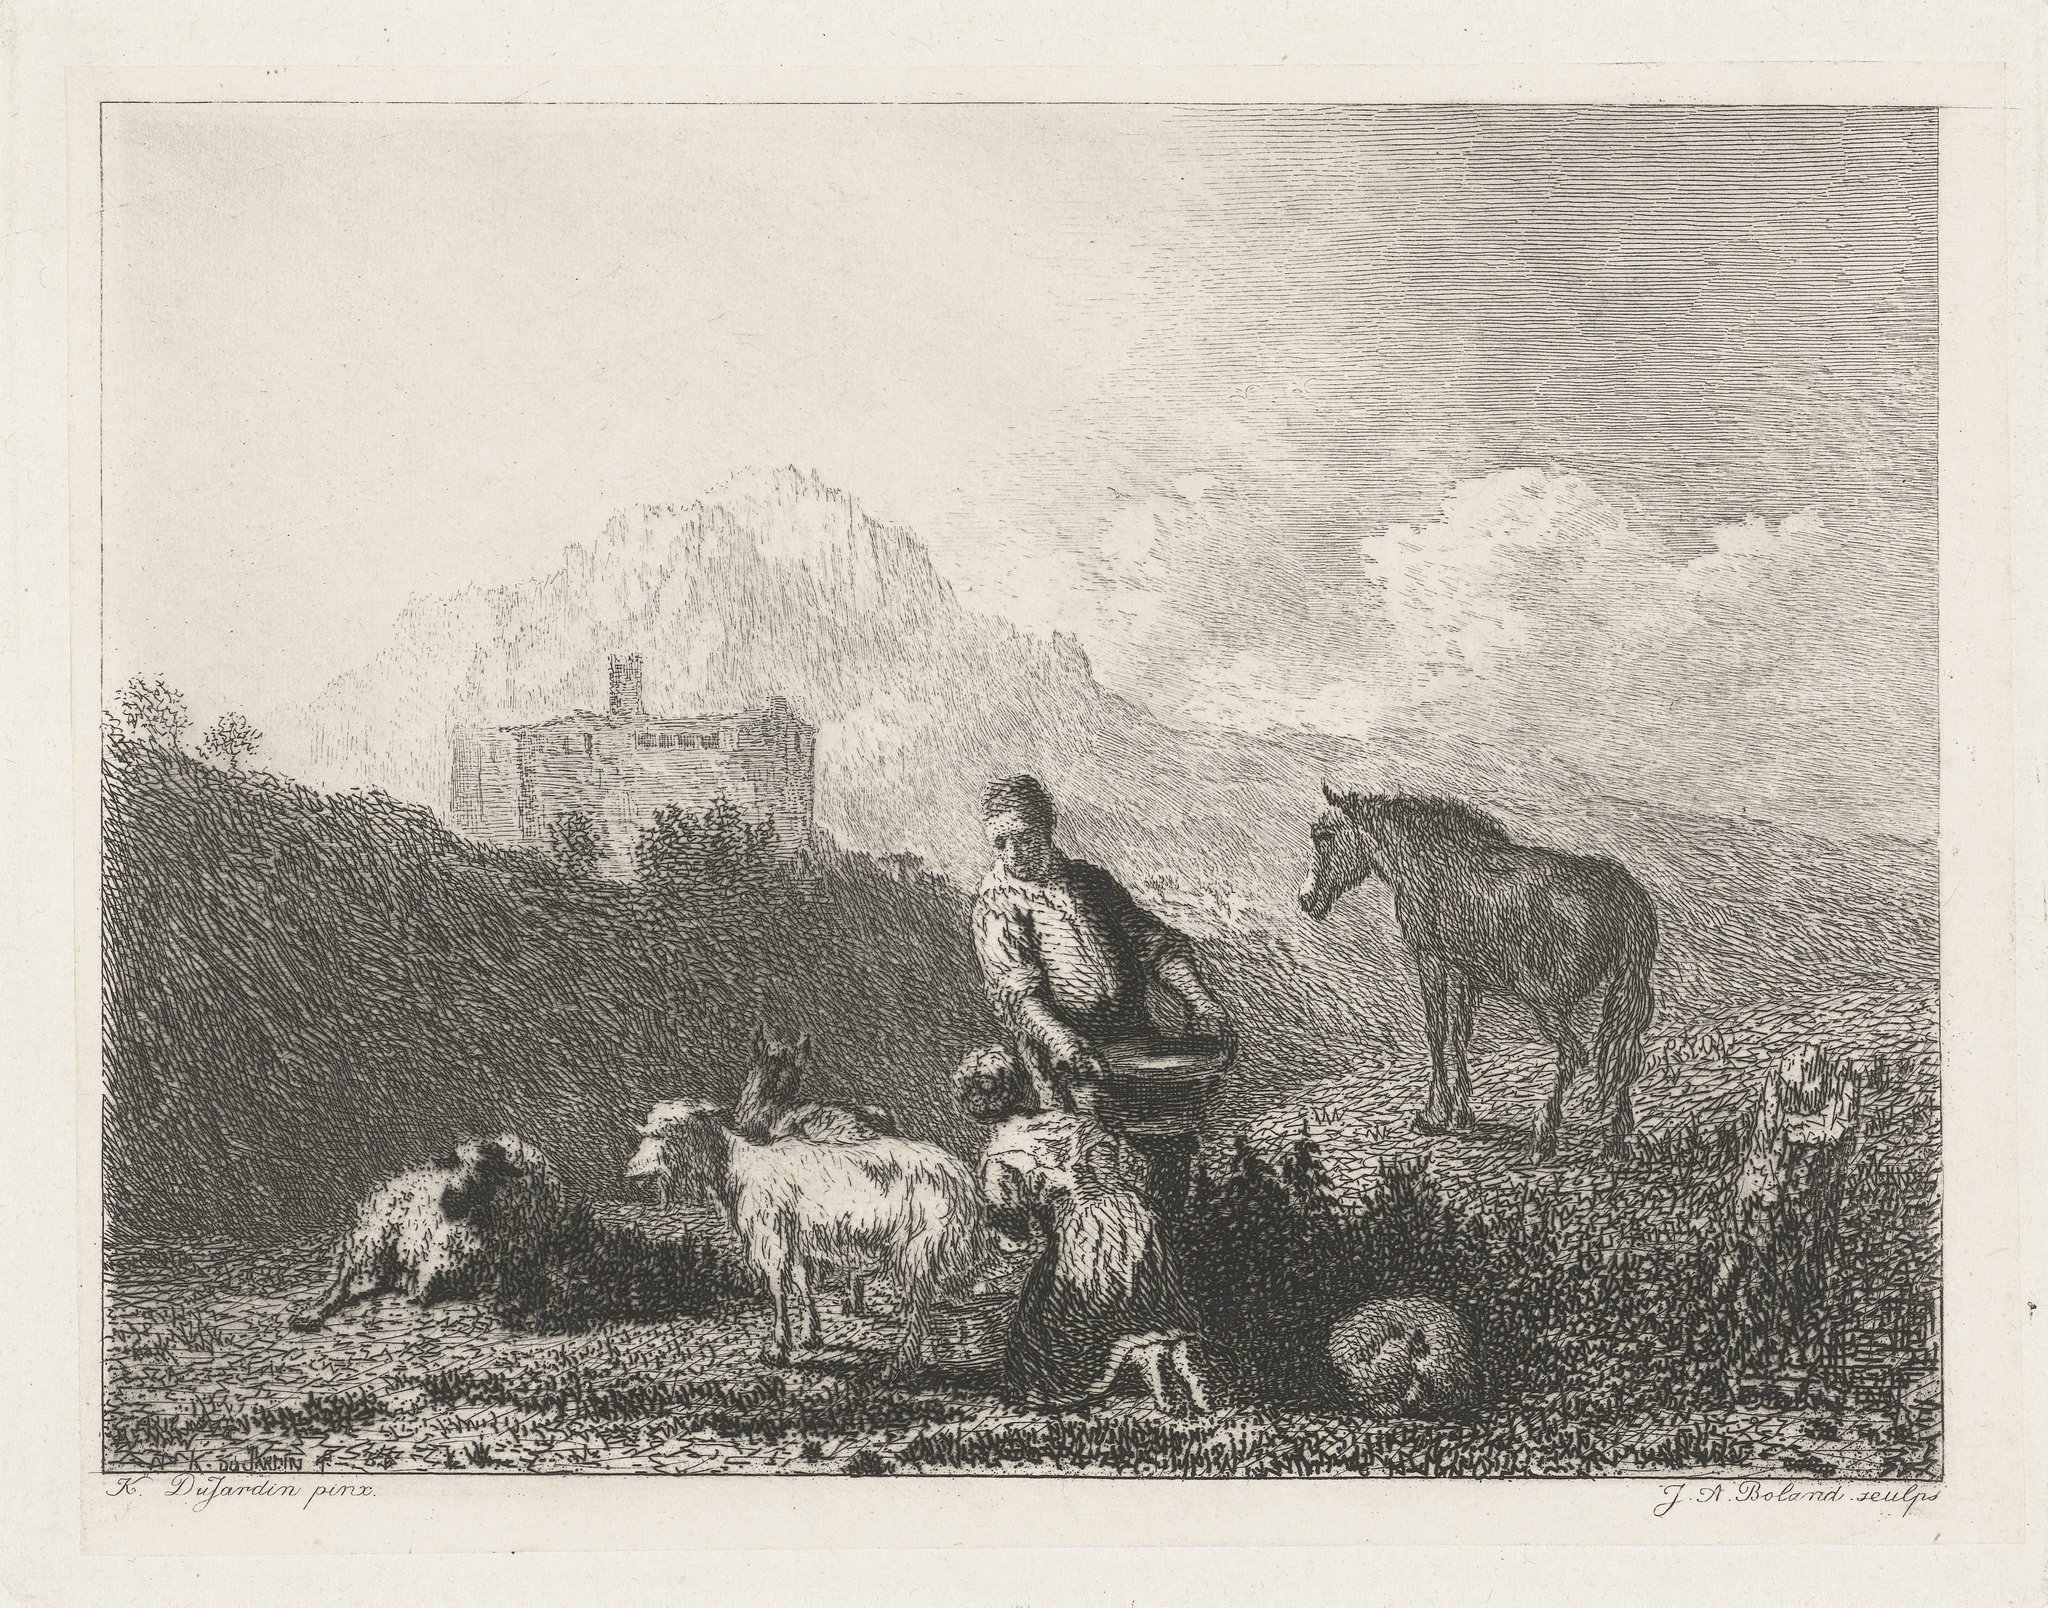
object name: print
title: Italiaans landschap met geitenmelkster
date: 1875-1876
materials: paper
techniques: drypoint, etching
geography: amsterdam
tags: pastorals, arcadian scenes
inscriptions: collector's mark: Lugt 2228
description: Reproductie van een schilderij uit de collectie van het Rijksmuseum Amsterdam, SK-A-192. Prent afkomstig uit: Brink, J. ten (et al.). Het Rijksmuseum te Amsterdam: [25] etsen van J.A. Boland. Haarlem: J.M. Schalekamp, [1875-1876] (13 A 20).